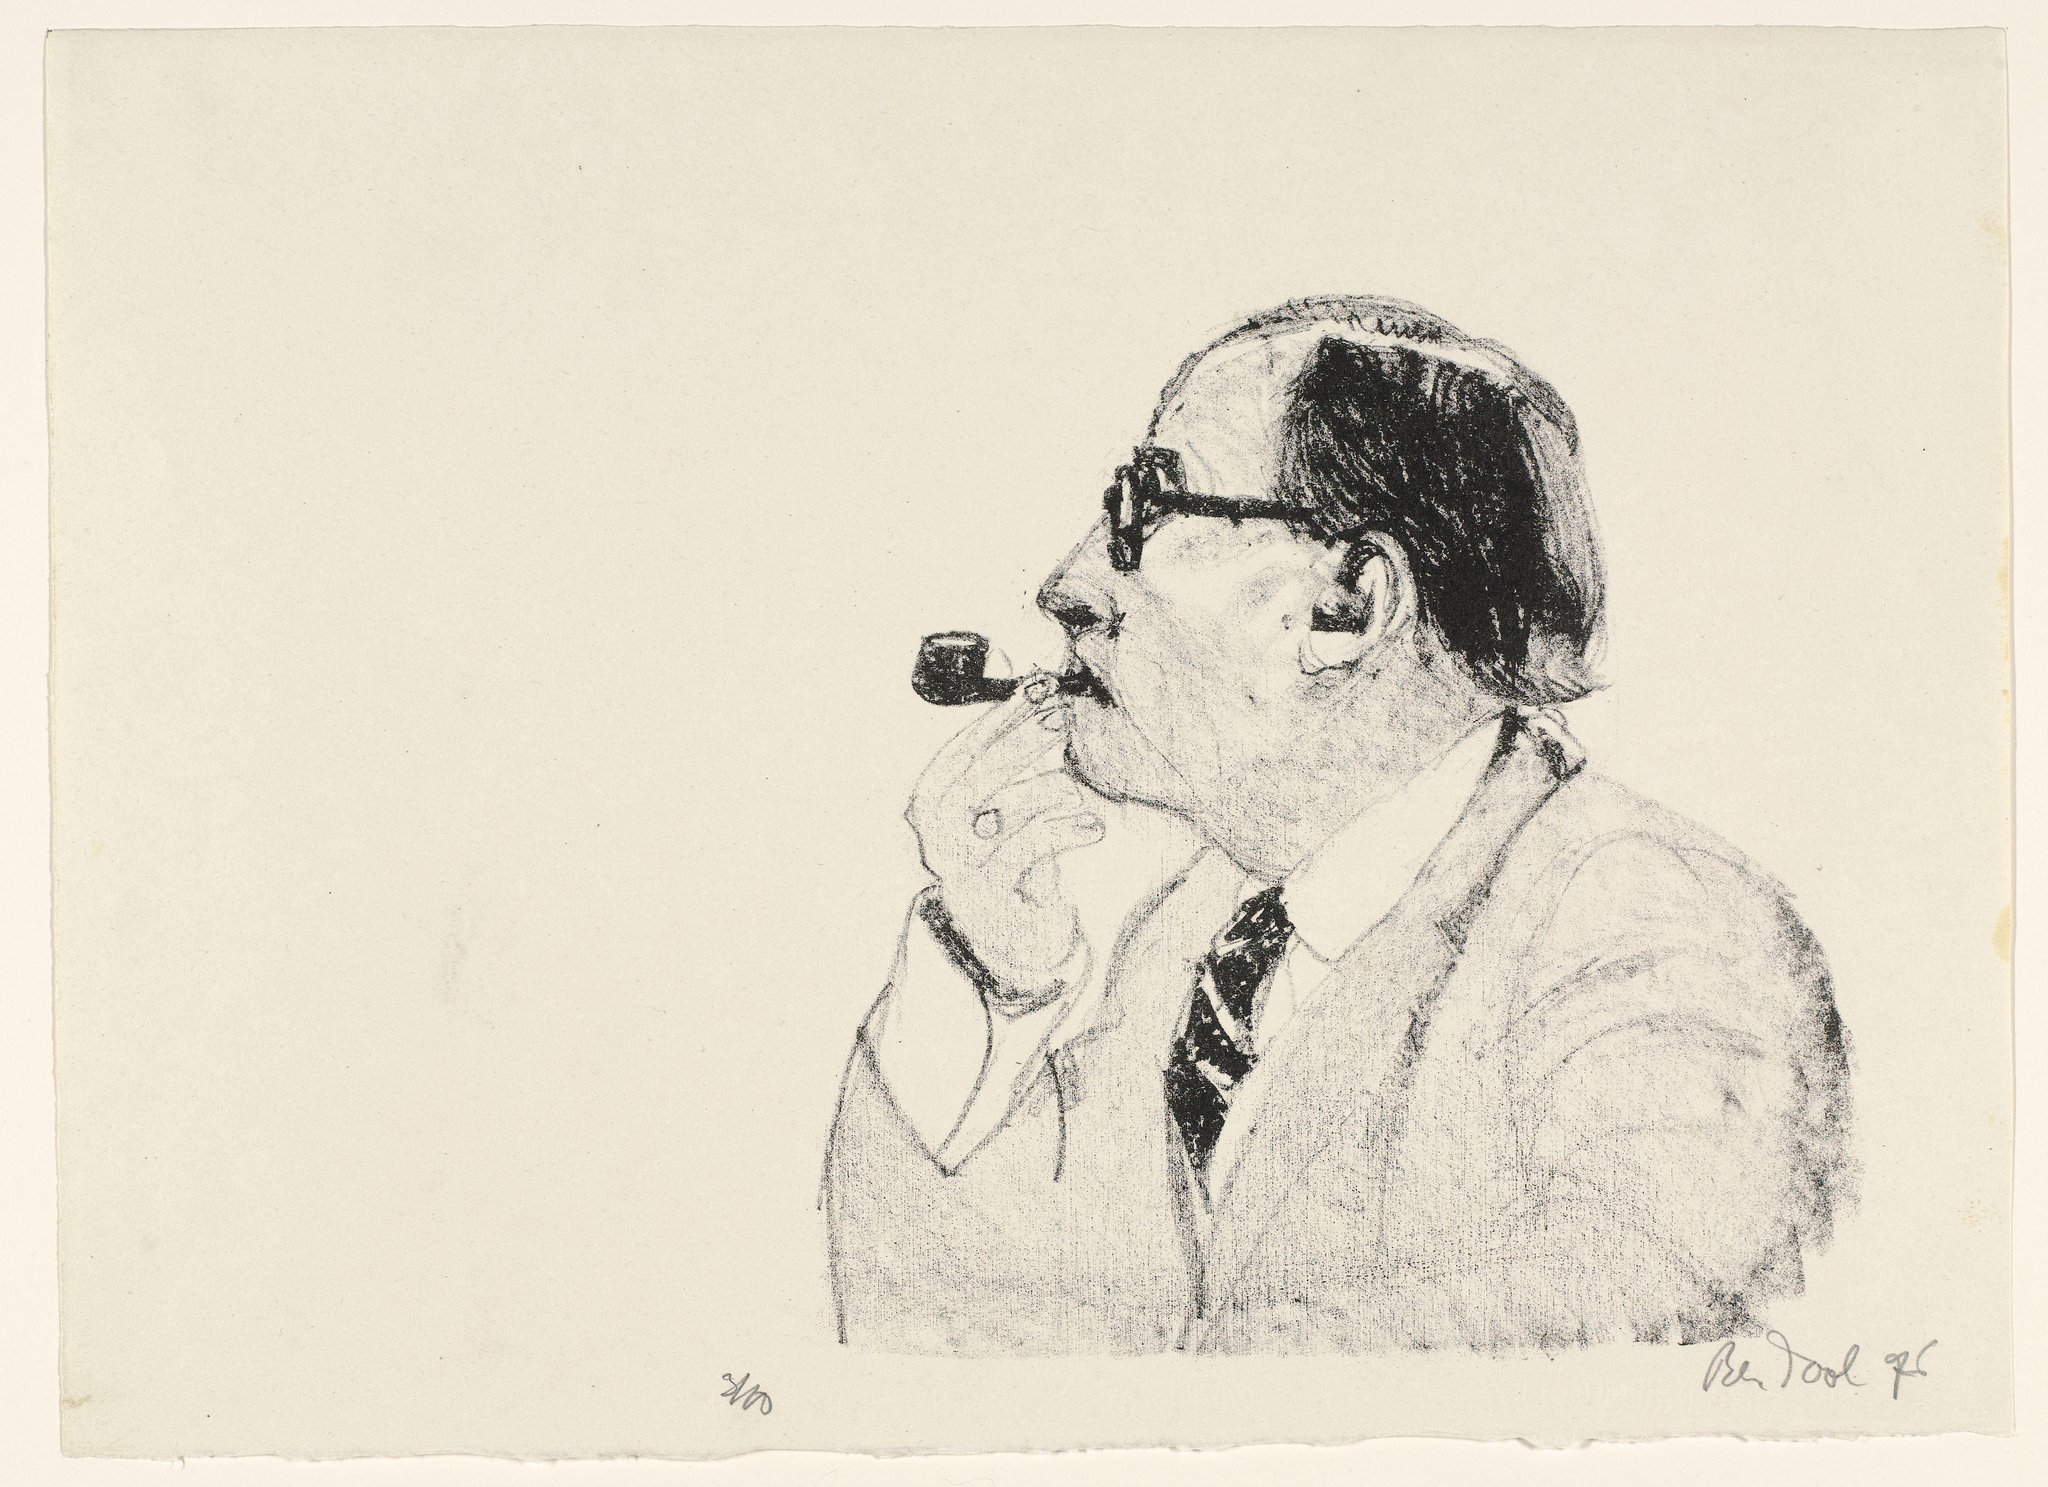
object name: print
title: Portret van Kees Cath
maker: rein dool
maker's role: draughtsman, painter, print maker, sculptor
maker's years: 1933-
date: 1976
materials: paper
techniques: lithograph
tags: universiteit van leiden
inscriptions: signature and date: ‘Rein Dool 76’, edition: ‘3/10’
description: De serietitel is door het museum toegekend bij gebrek aan informatie over een originele serietitel.